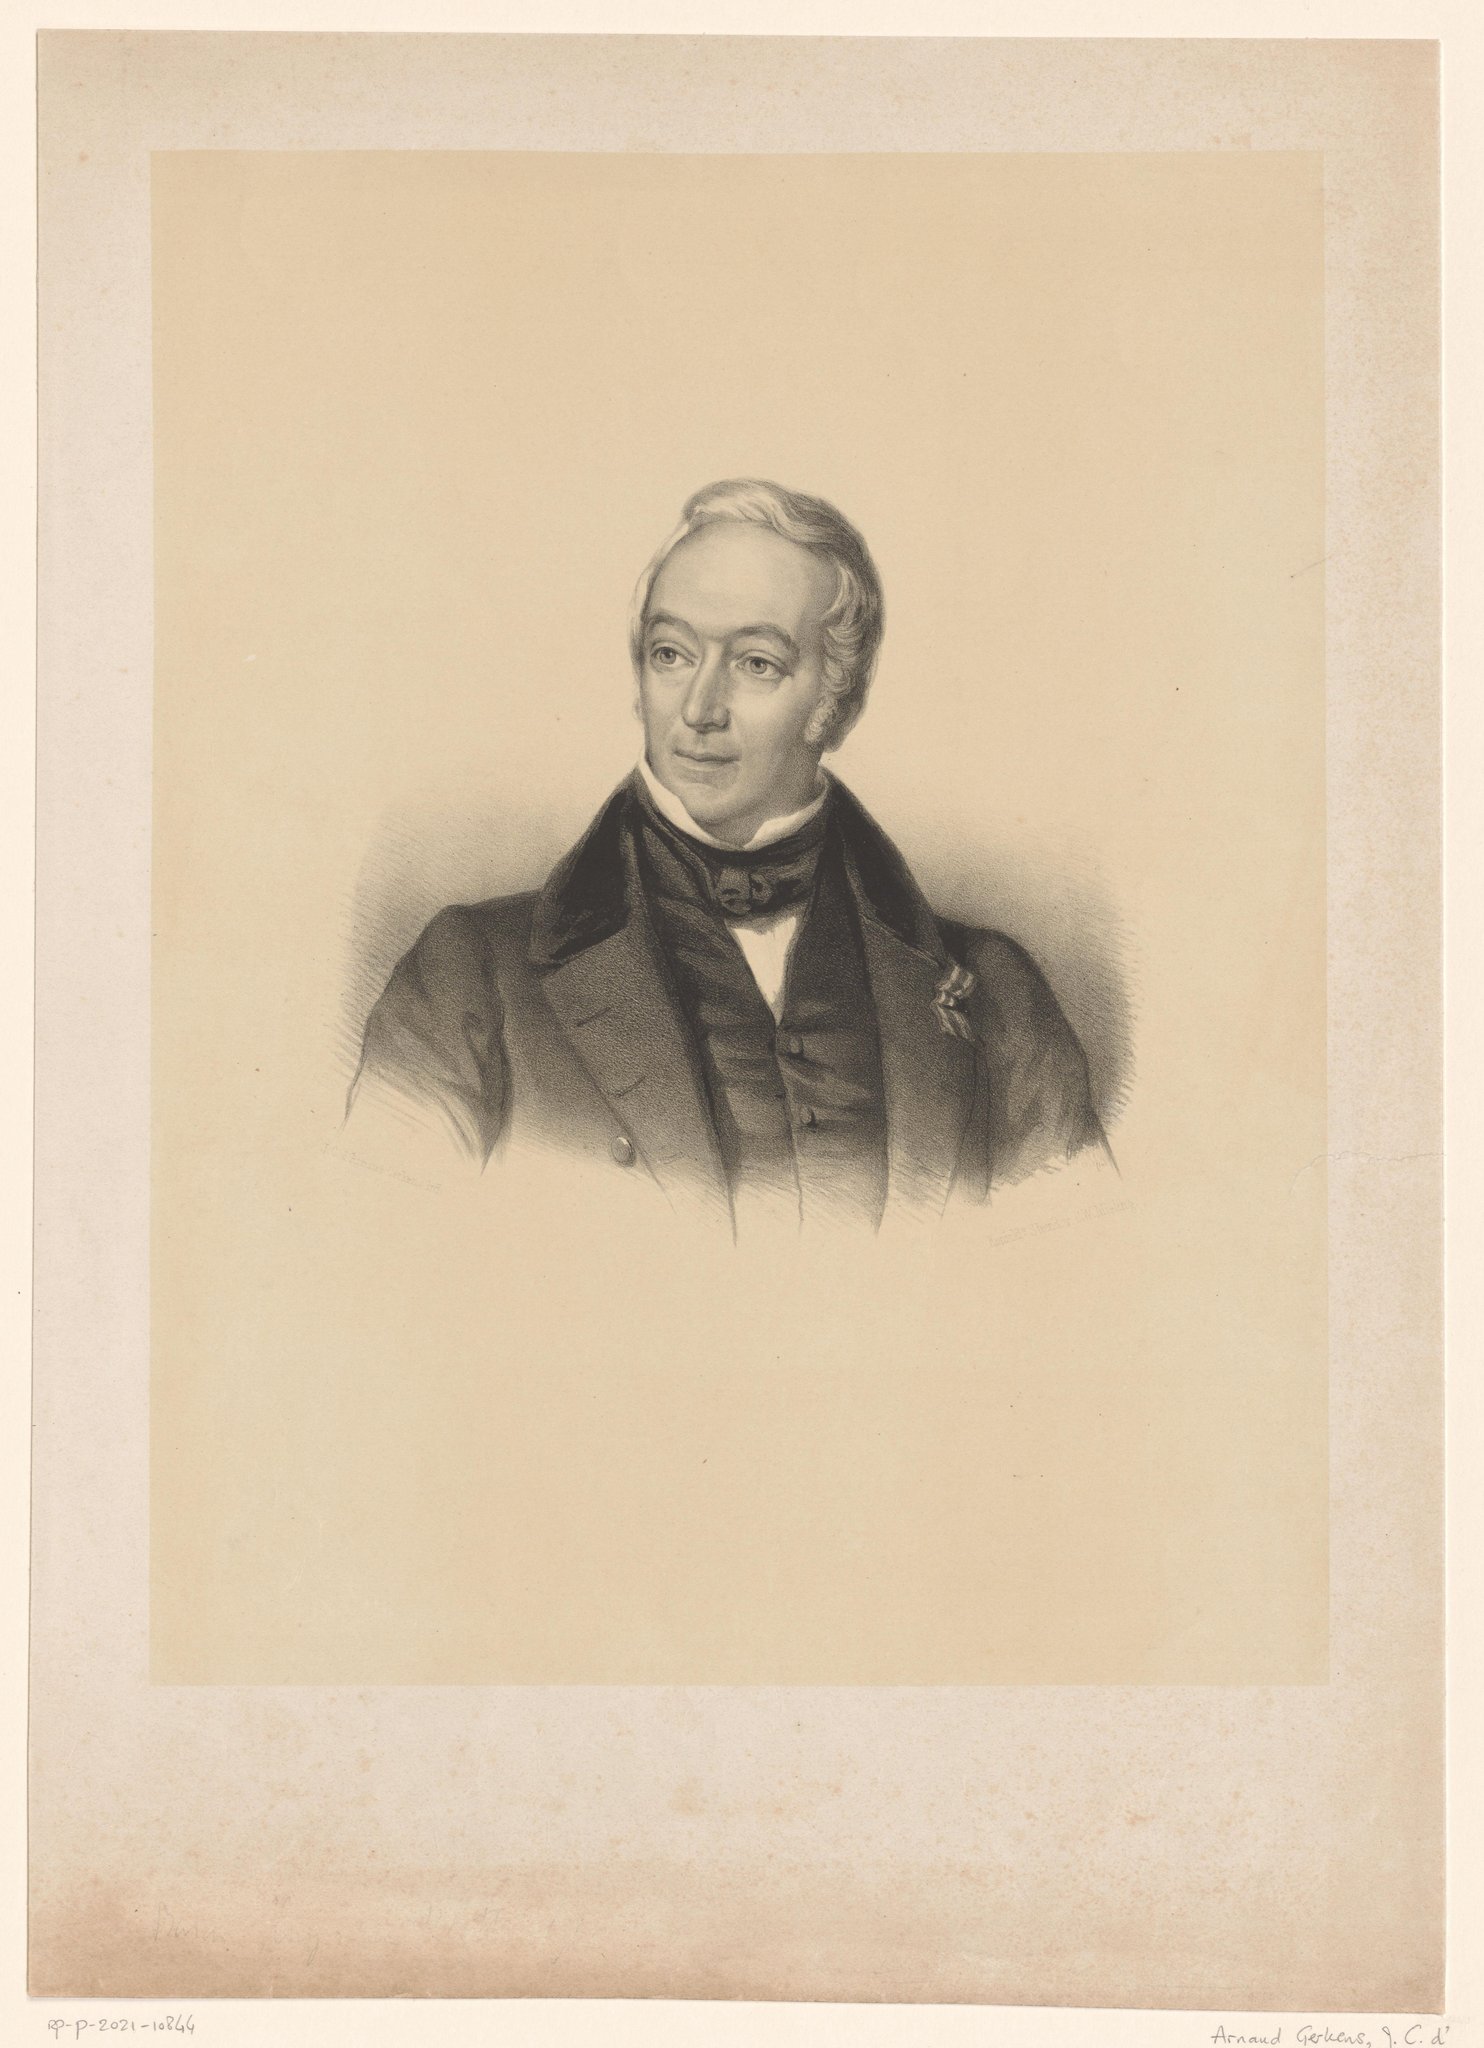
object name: print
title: Portret van Jan Willem Huyssen van Kattendijke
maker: johannes christiaan d arnaud gerkens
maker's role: draughtsman, print maker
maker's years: 1823-1892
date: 1833-1865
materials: paper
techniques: tone lithography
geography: the hague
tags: middelburg, paris, historical persons